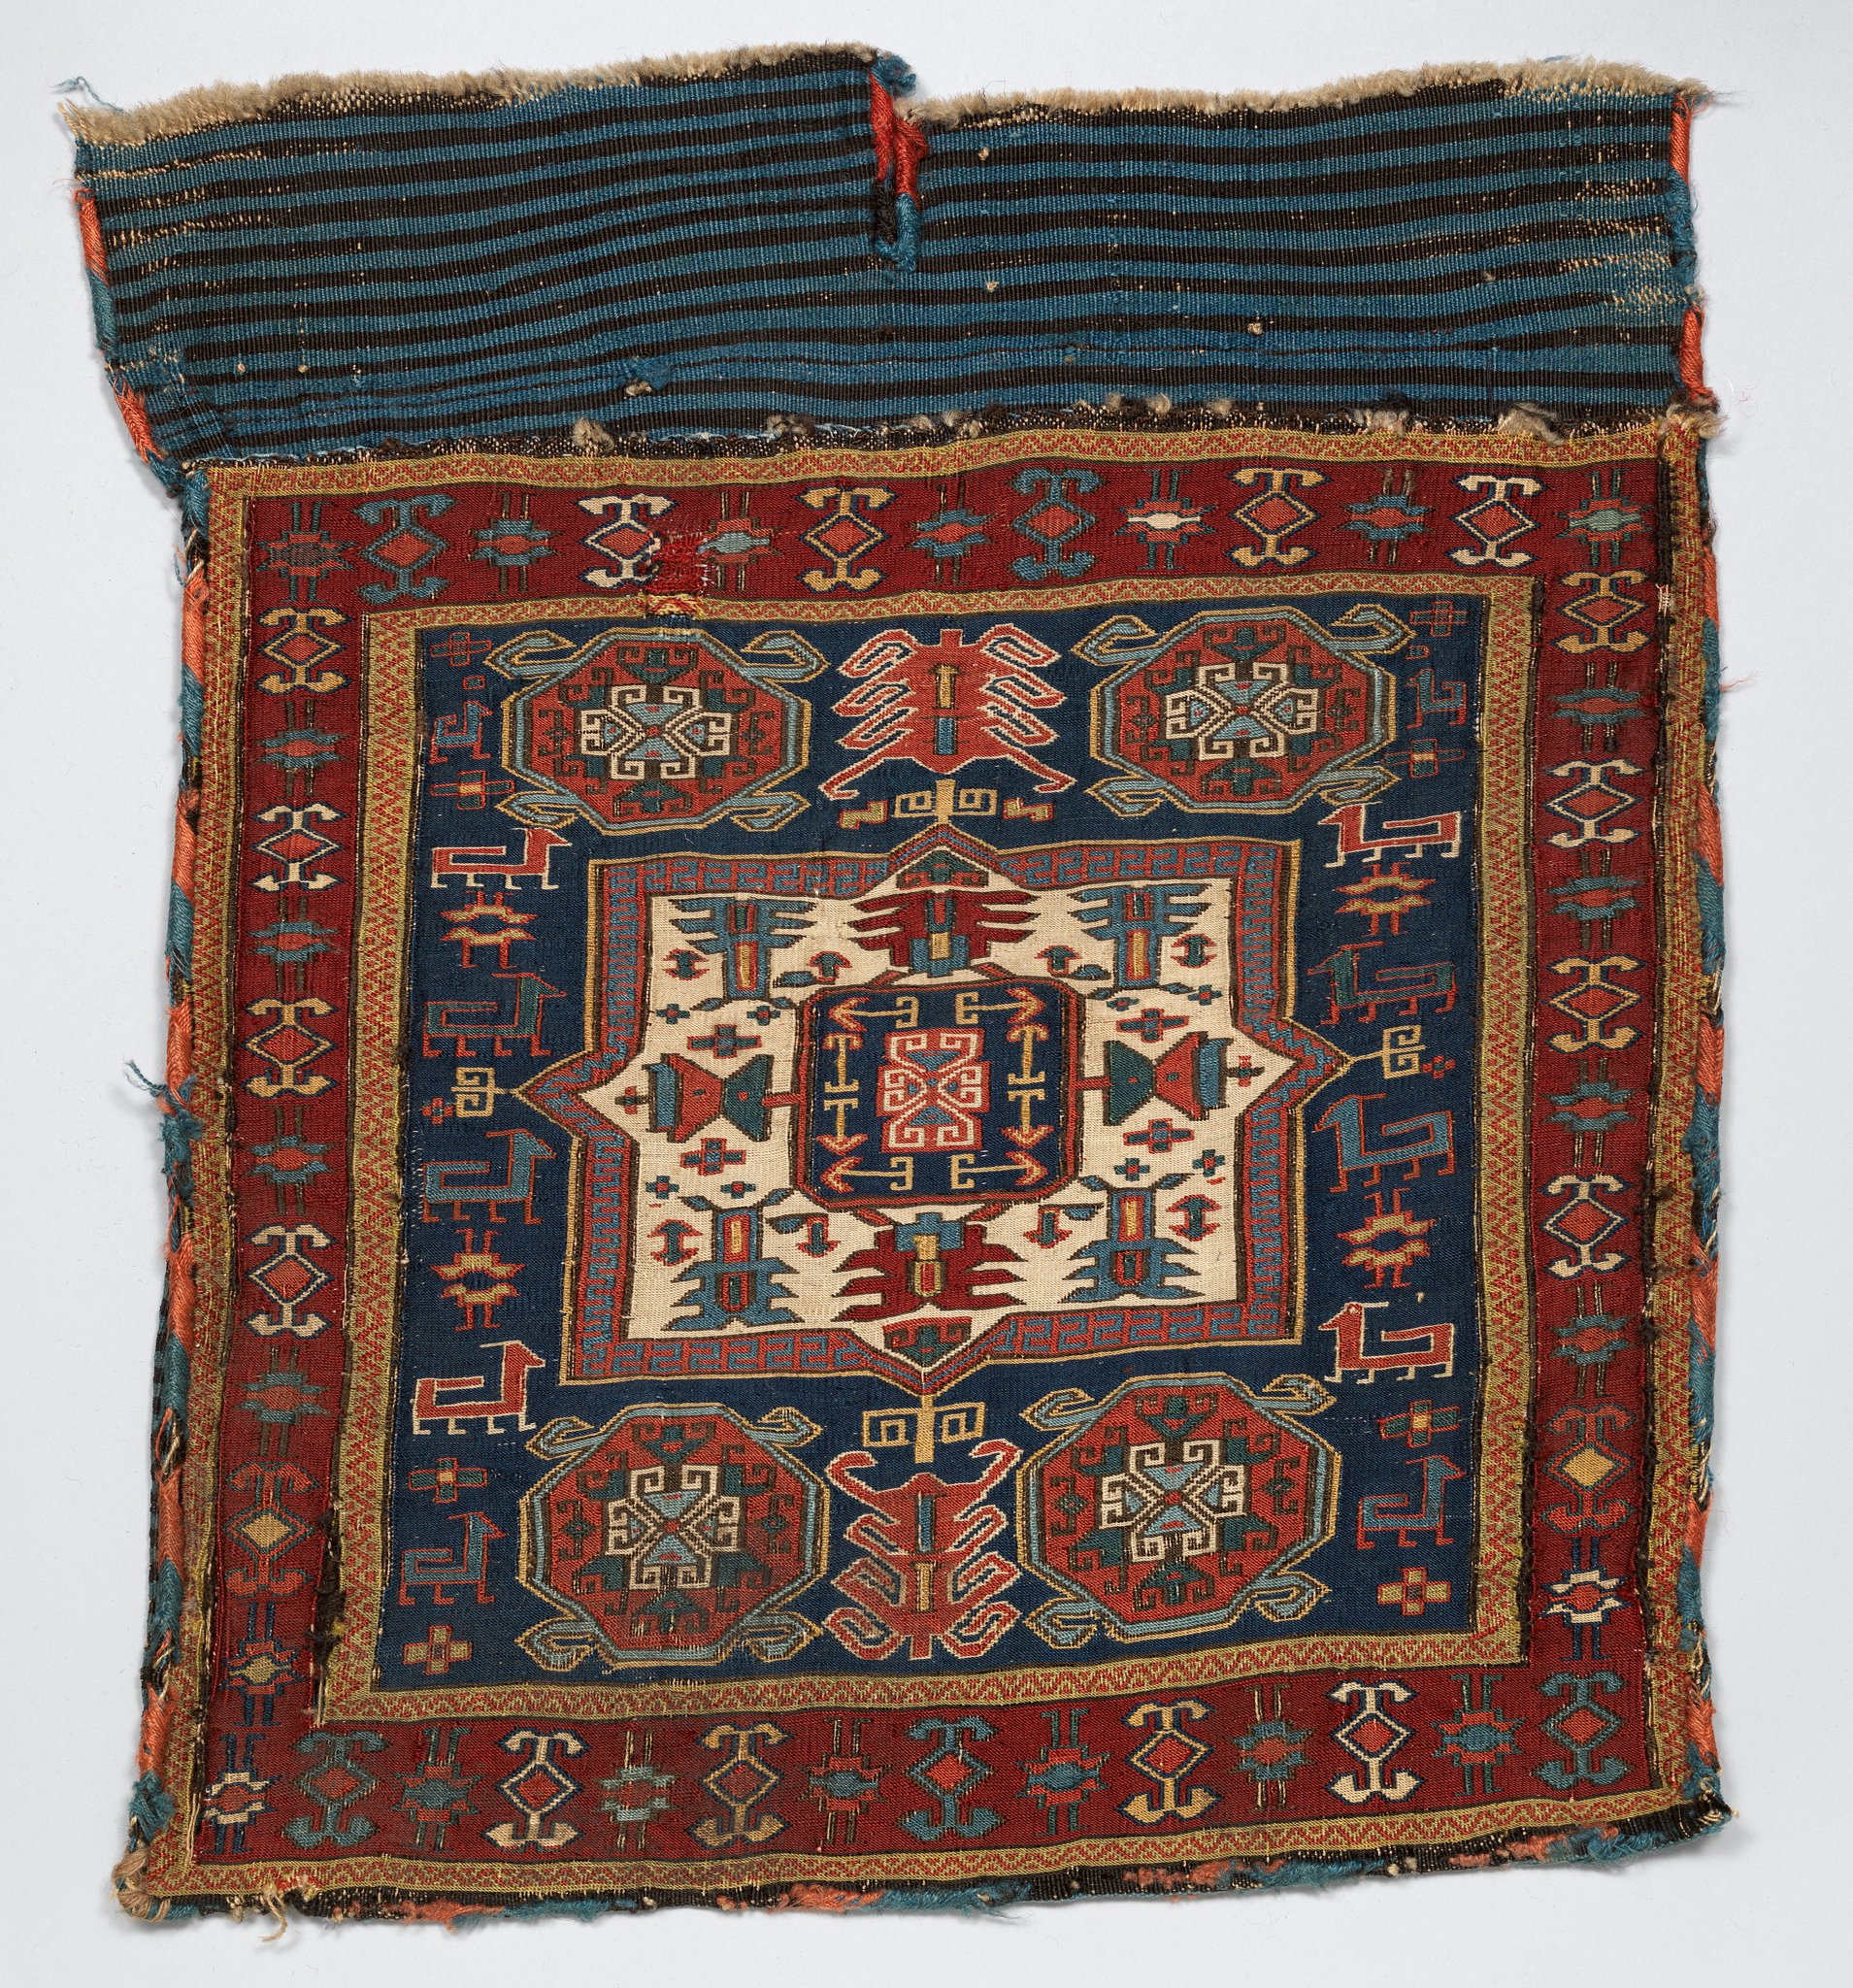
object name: saddle bag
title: Face of half a Double Saddle Bag (Khorjin)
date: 1850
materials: wool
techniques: weave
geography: iran